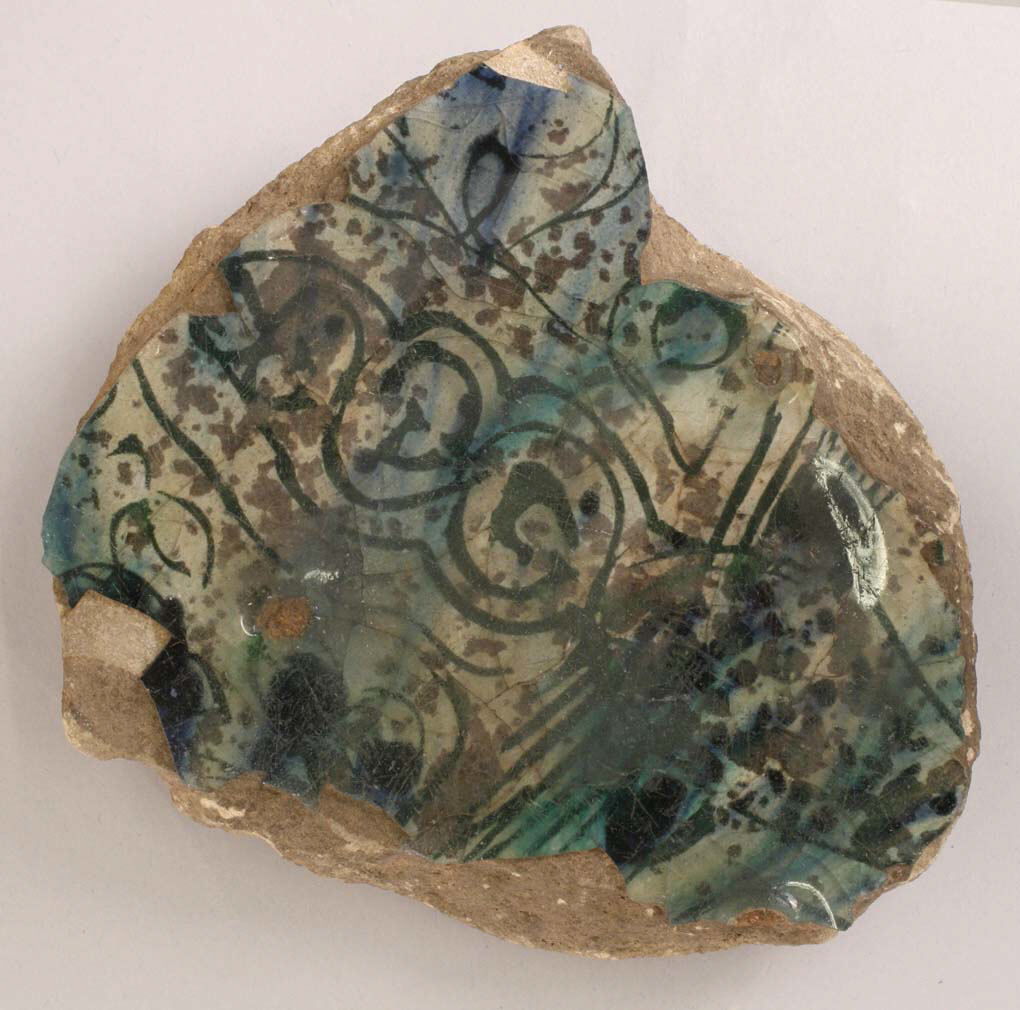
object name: ceramic fragment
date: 1301-1500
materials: glaze, stonepaste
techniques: painting, polychrome, underglaze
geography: egypt or syria